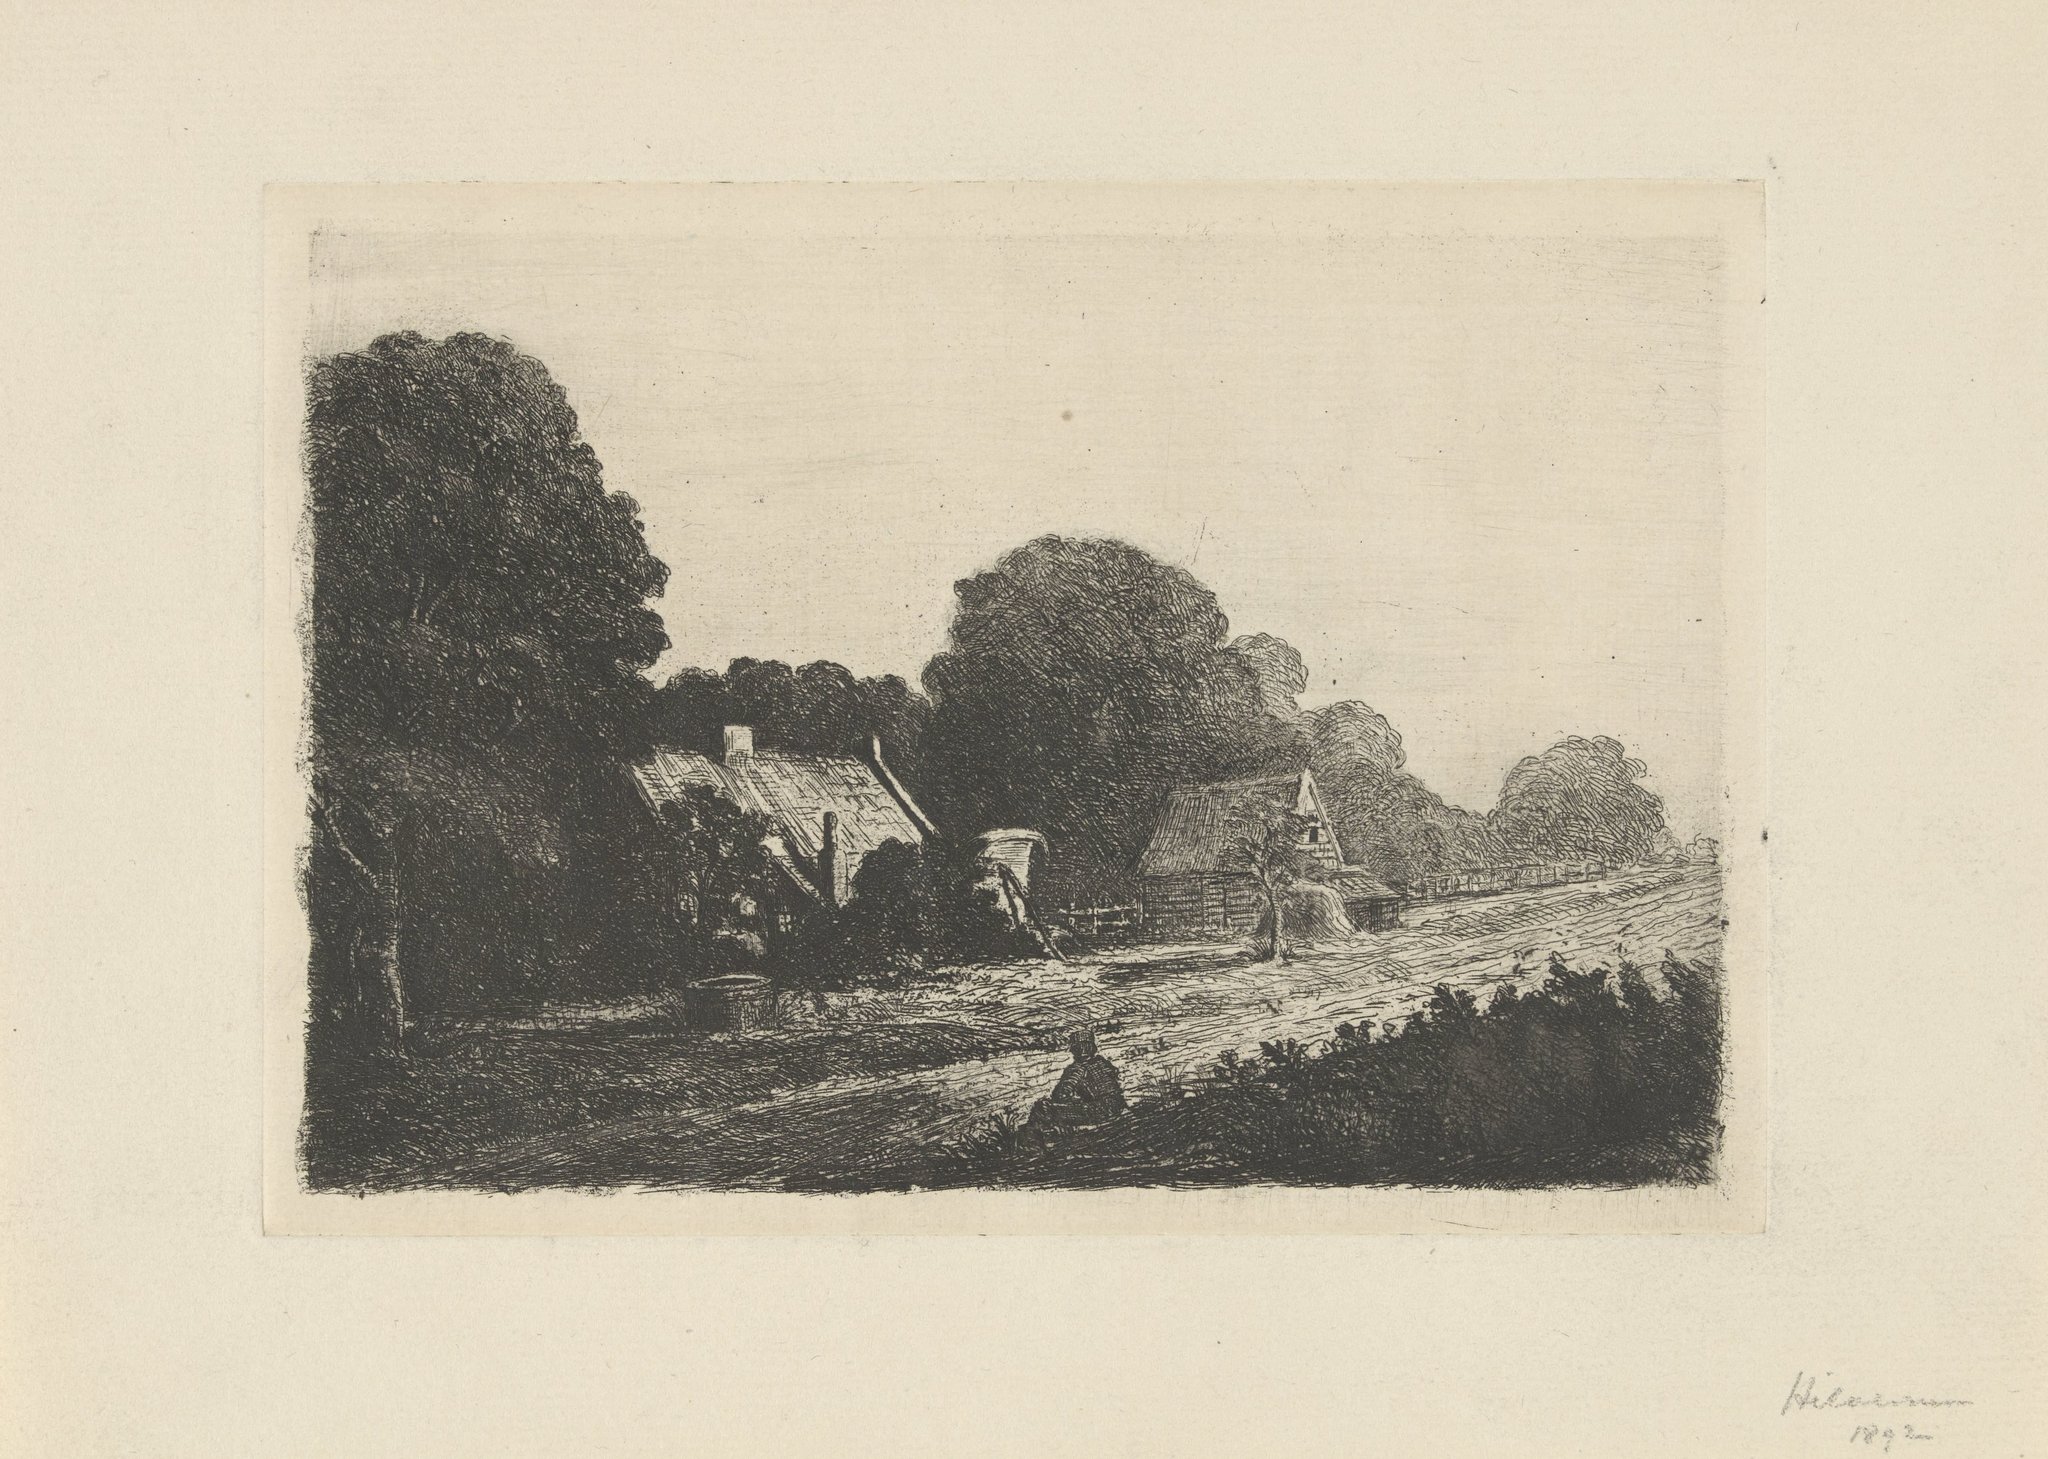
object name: print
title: Landweg bij Hilversum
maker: jonkheer barthold willem floris van riemsdijk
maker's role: engineer, print maker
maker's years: 1850-1942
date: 1892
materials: paper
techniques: etching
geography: netherlands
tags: road, path, farm or solitary house in landscape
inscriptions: inscription: ‘Hilversum 1892’, collector's mark: Lugt 2228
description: Aan een landweg bij Hilversum liggen twee huizen die worden overschaduwd door geboomte. Op de voorgrond zit een man aan de rand van de weg.